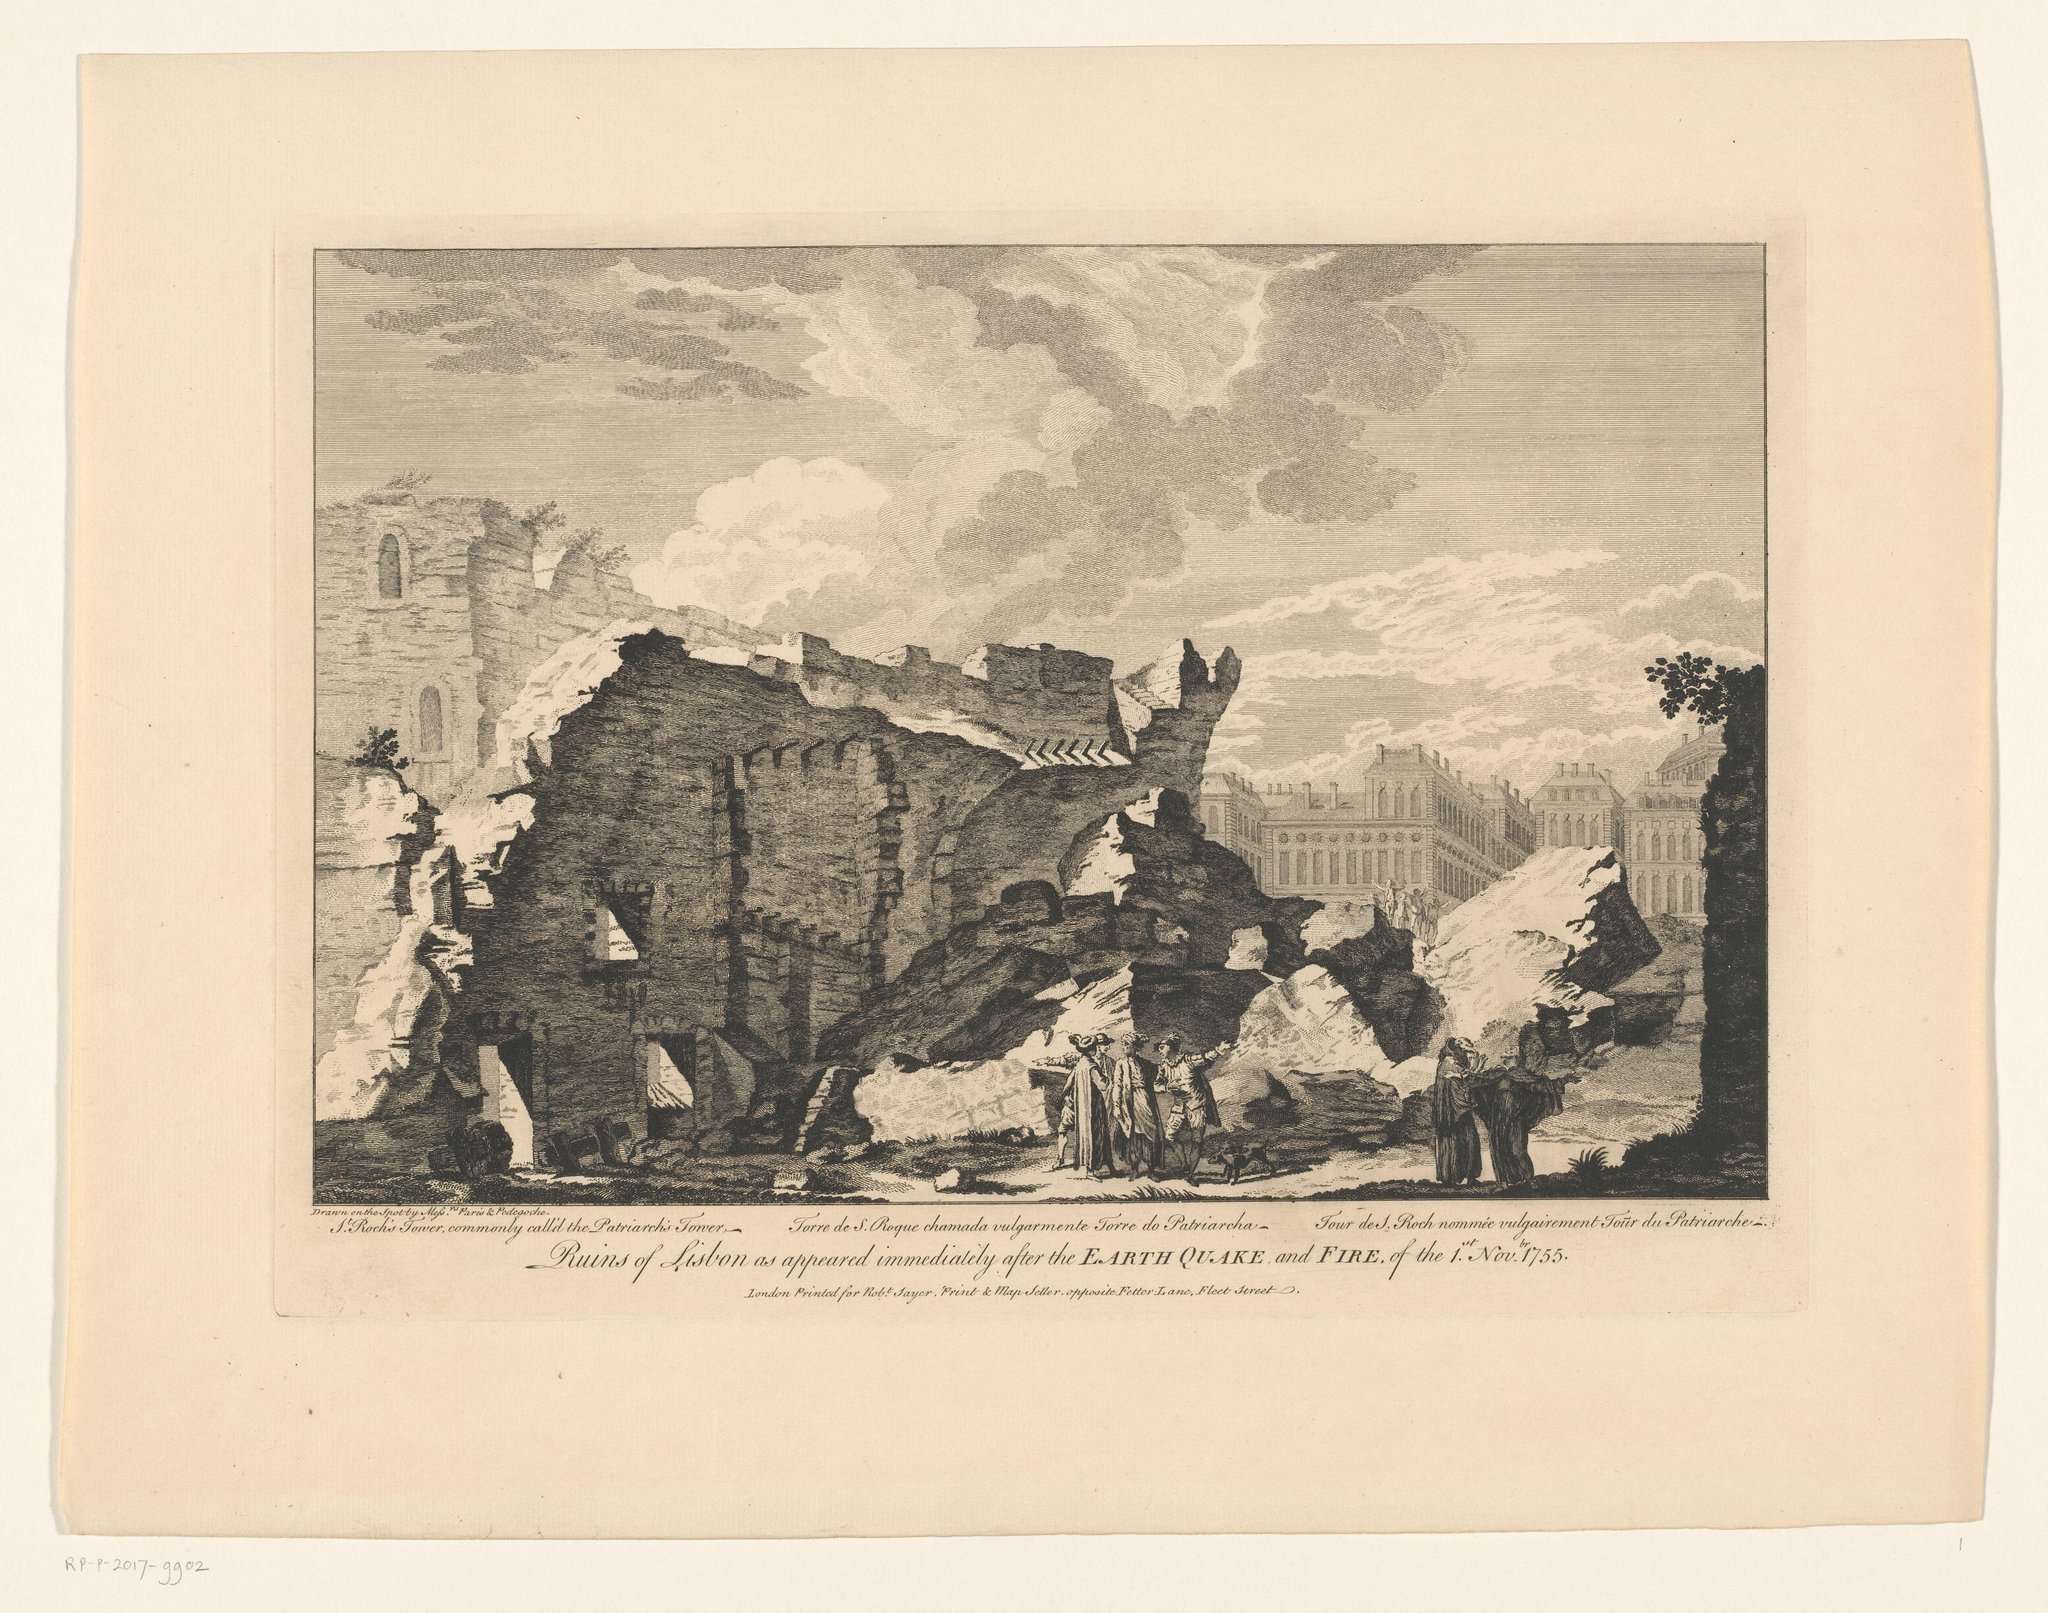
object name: print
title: St Roch's Tower commonly call'd the Patriarch's Tower / torre se S. Roque chamada vulgarmente Torre do Patriarcha / Tour de S Roche nommée vulgairement Tour du Patriarche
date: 1758-1760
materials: paper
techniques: etching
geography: london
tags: ruin of a building ~ architecture, consequences of an earthquake, ruin of church, monastery, etc.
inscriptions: collector's mark: Lugt 2228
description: Ruïne van de toren van St. Rochus of Patriarchen in Lissabon. Onderdeel van een serie van zes prenten van de ruïnes van de stad Lissabon na de grote aardbeving van 1 november 1755. Kopieën naar de oorspronkelijke prentserie door J.P. Le Bas van 1758, naar tekeningen van lokale kunstenaars, waarschijnlijk amateurs, aangeduid als Paris & Pedegoche.